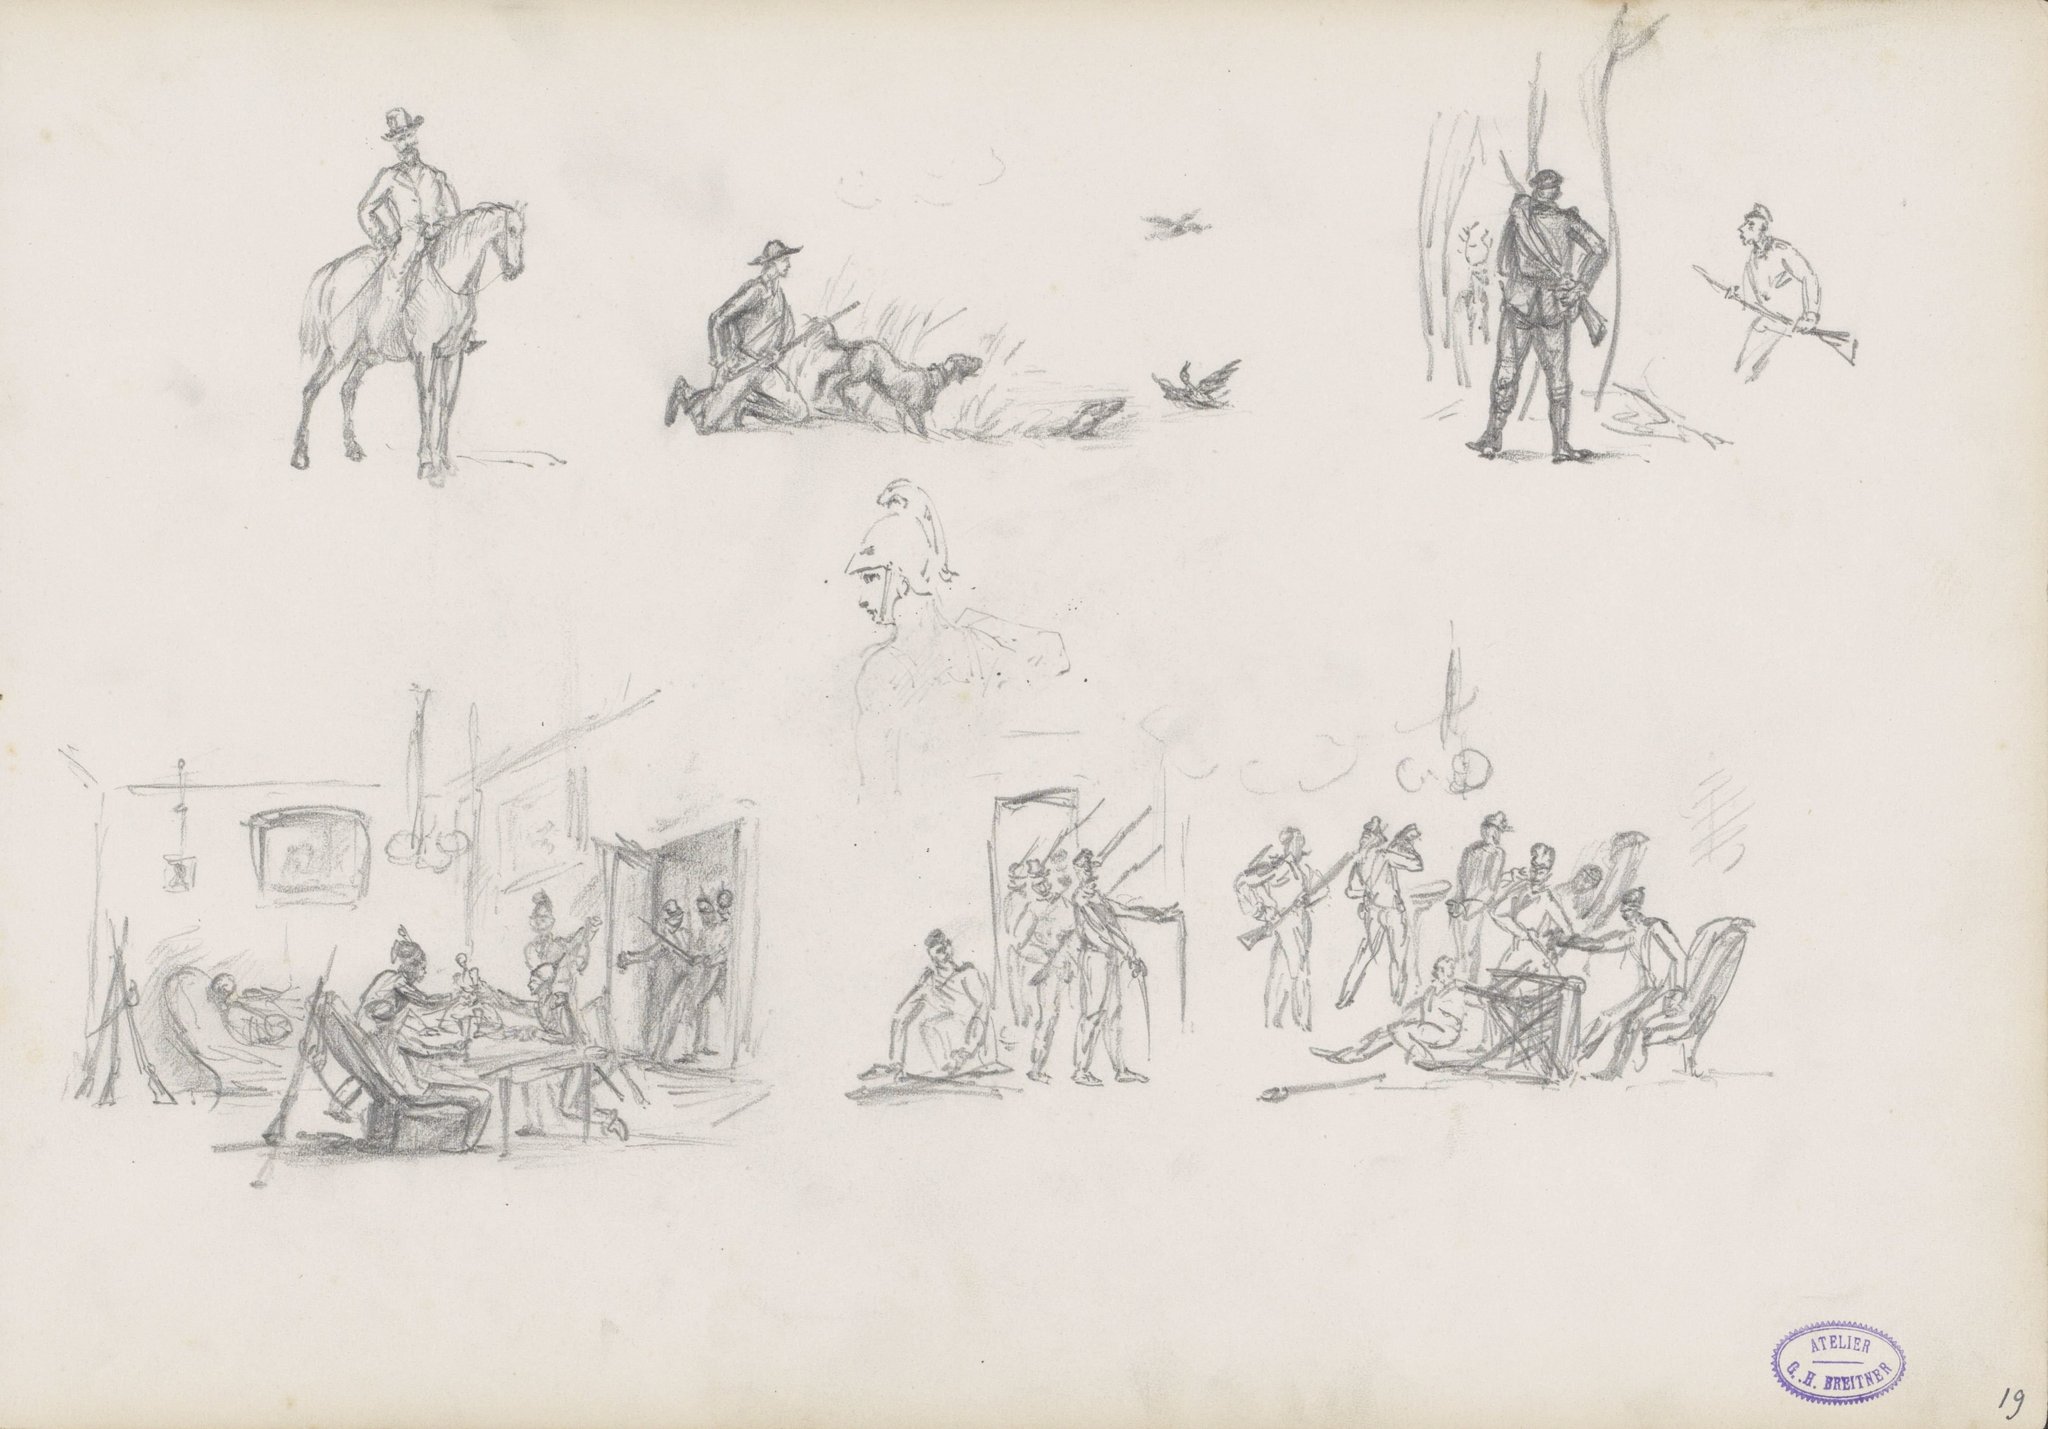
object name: drawing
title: Jagers en soldaten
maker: george hendrik breitner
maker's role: draughtsman, painter, print maker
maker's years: 1857-1923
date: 1873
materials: paper, pencil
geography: rotterdam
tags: the soldier; the soldier's life (+ weapons), civic architecture; edifices; dwellings - aa - civic architecture: inside, hunters hunting (n.b.: in 1988-1990 this notation denoted the concept of 43c11421 'hunters resting during the hunt'), bird hunting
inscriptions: workshop stamp: Lugt 291d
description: Boven een jager te paard, een jager met hond op eenden- of ganzenjacht en twee hertenjagers. Onder soldaten met geweren in interieurs.